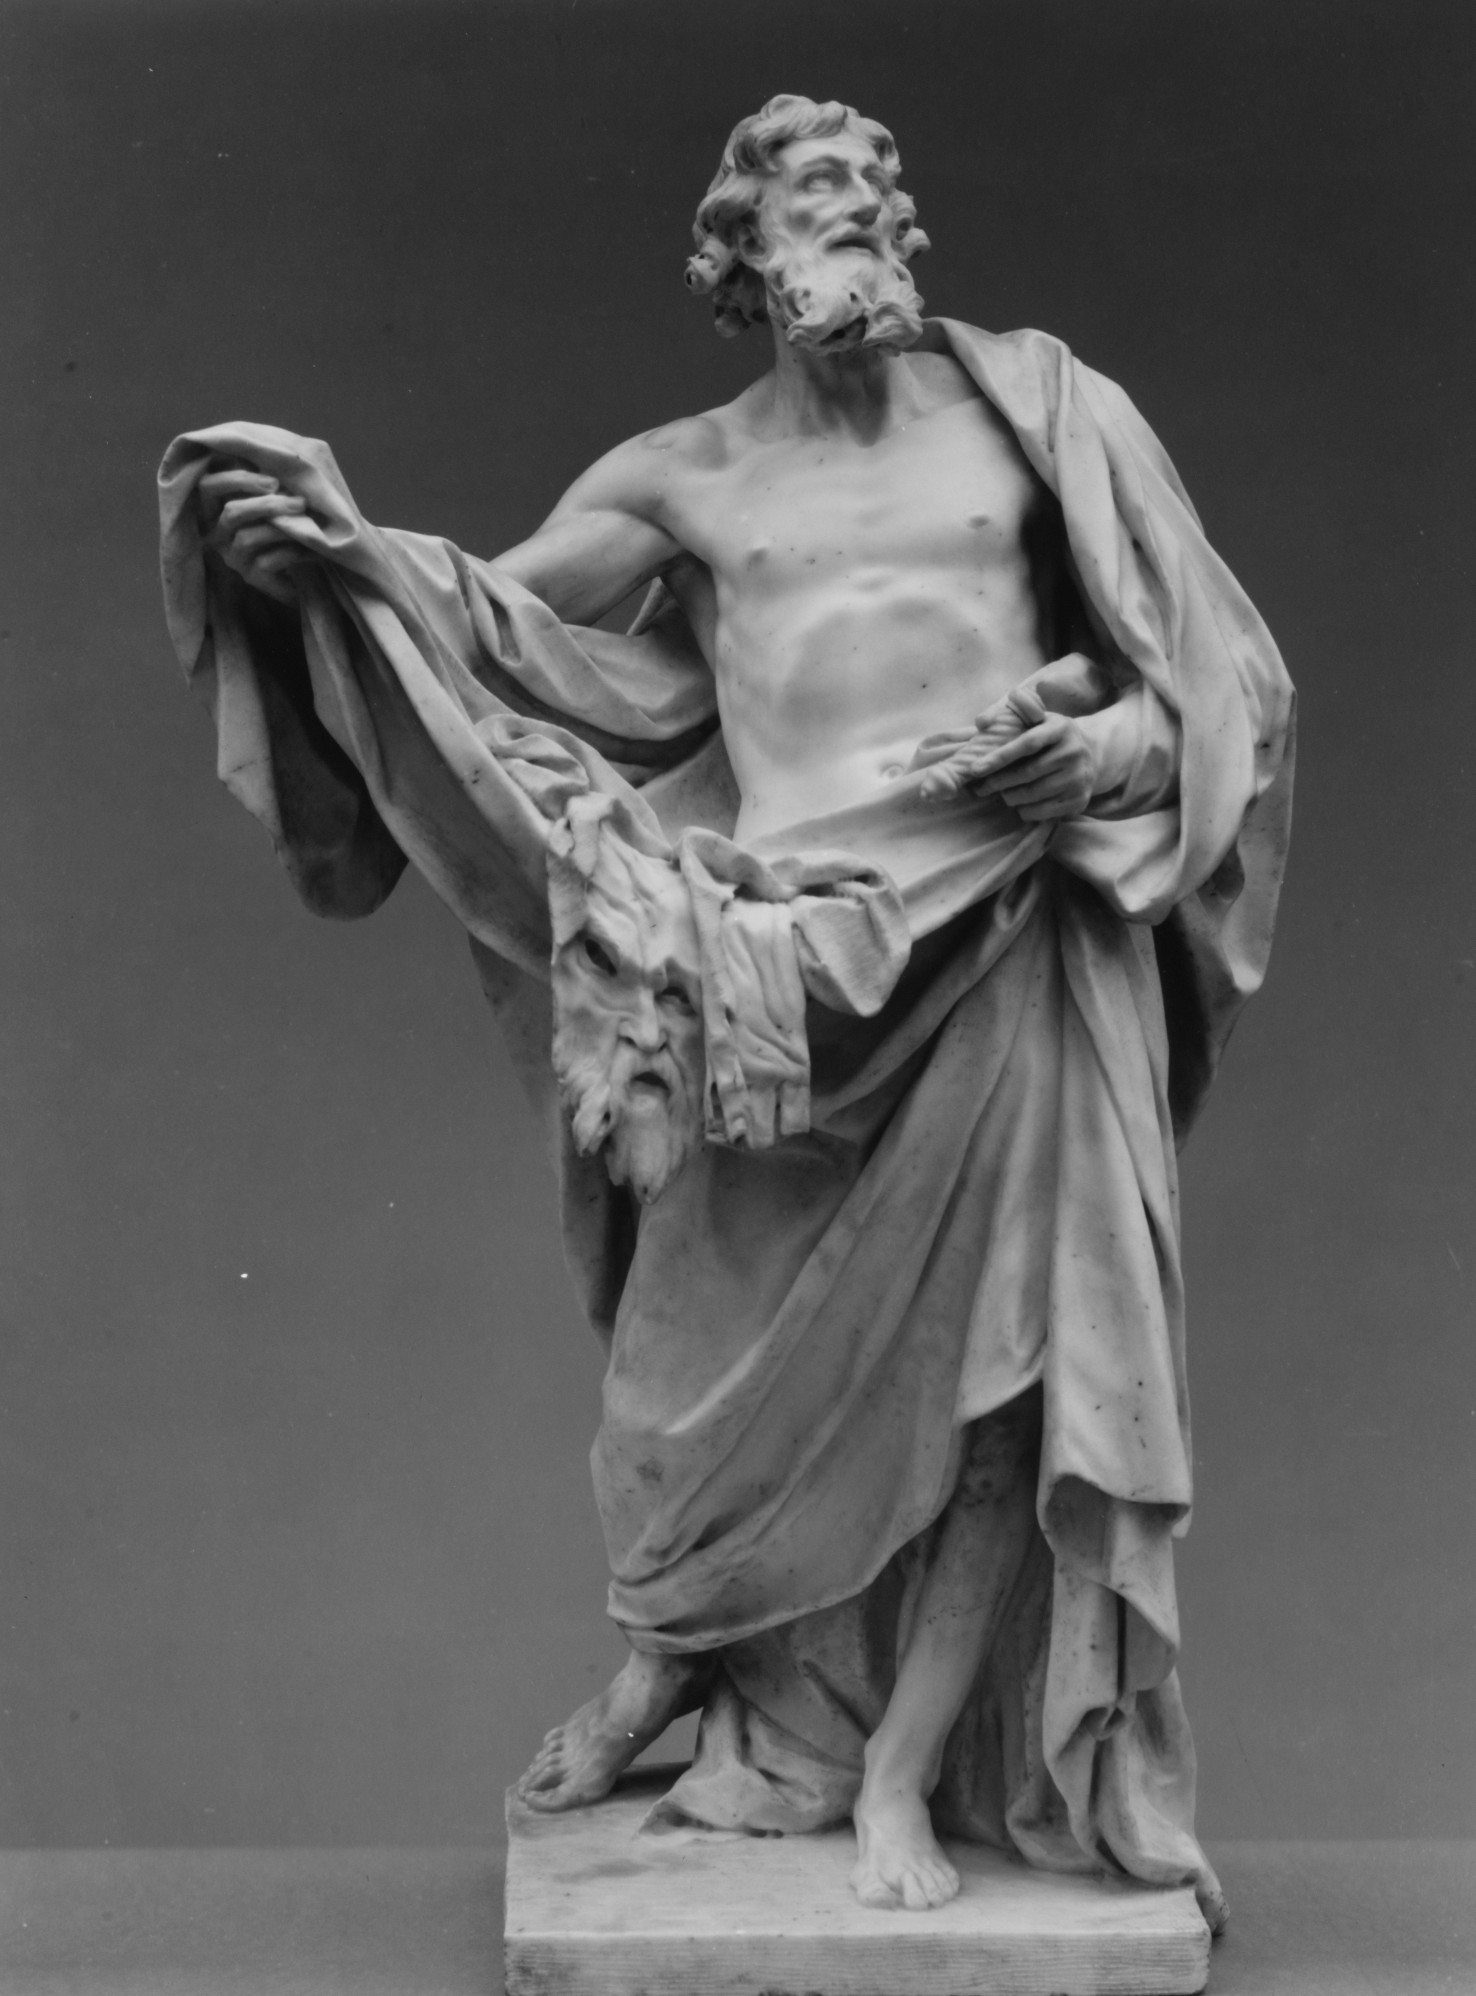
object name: statuette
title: Saint Bartholomew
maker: pierre legros ii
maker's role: artist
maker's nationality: italian, born france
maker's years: 1666-1719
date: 1738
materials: marble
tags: men,saints